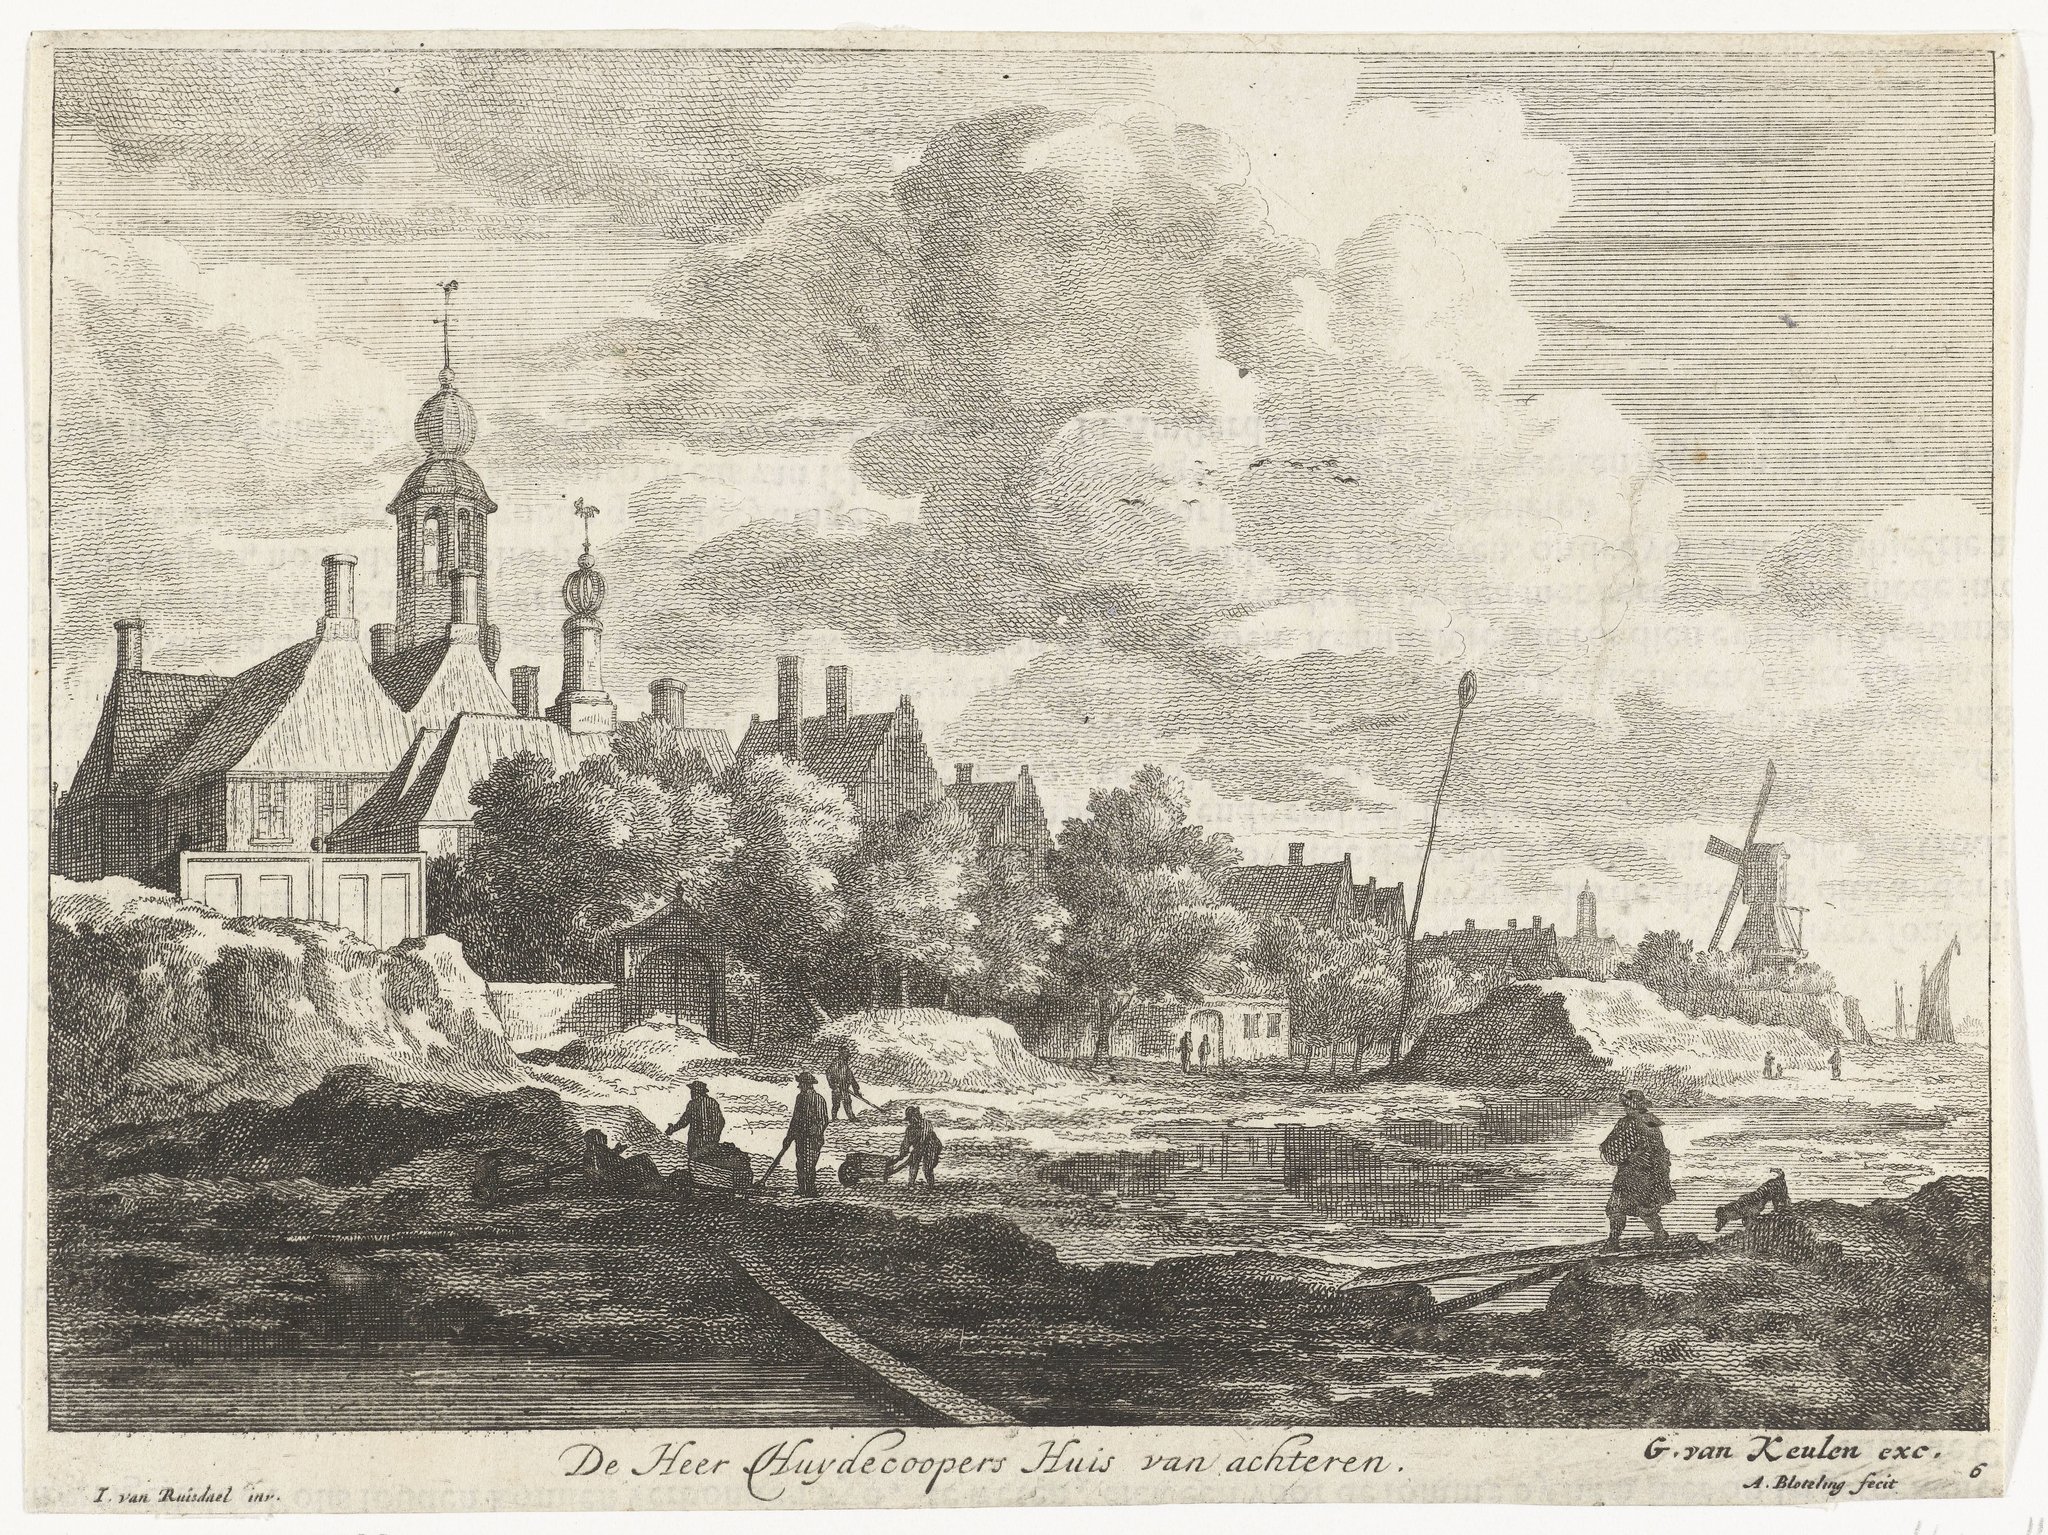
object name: print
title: De Heer Huydecoopers Huis van achteren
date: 1707-1727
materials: paper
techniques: etching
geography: amsterdam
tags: amsterdam, mayor, joan huydecoper van maarseveen (i)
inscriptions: collector's mark: Lugt 2228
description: Gezicht op de achterzijde van het huis van de burgermeester Joan Huydecoper van Maarsseveen. Op de voorgrond zijn arbeiders bezig met het graven van de Herengracht.